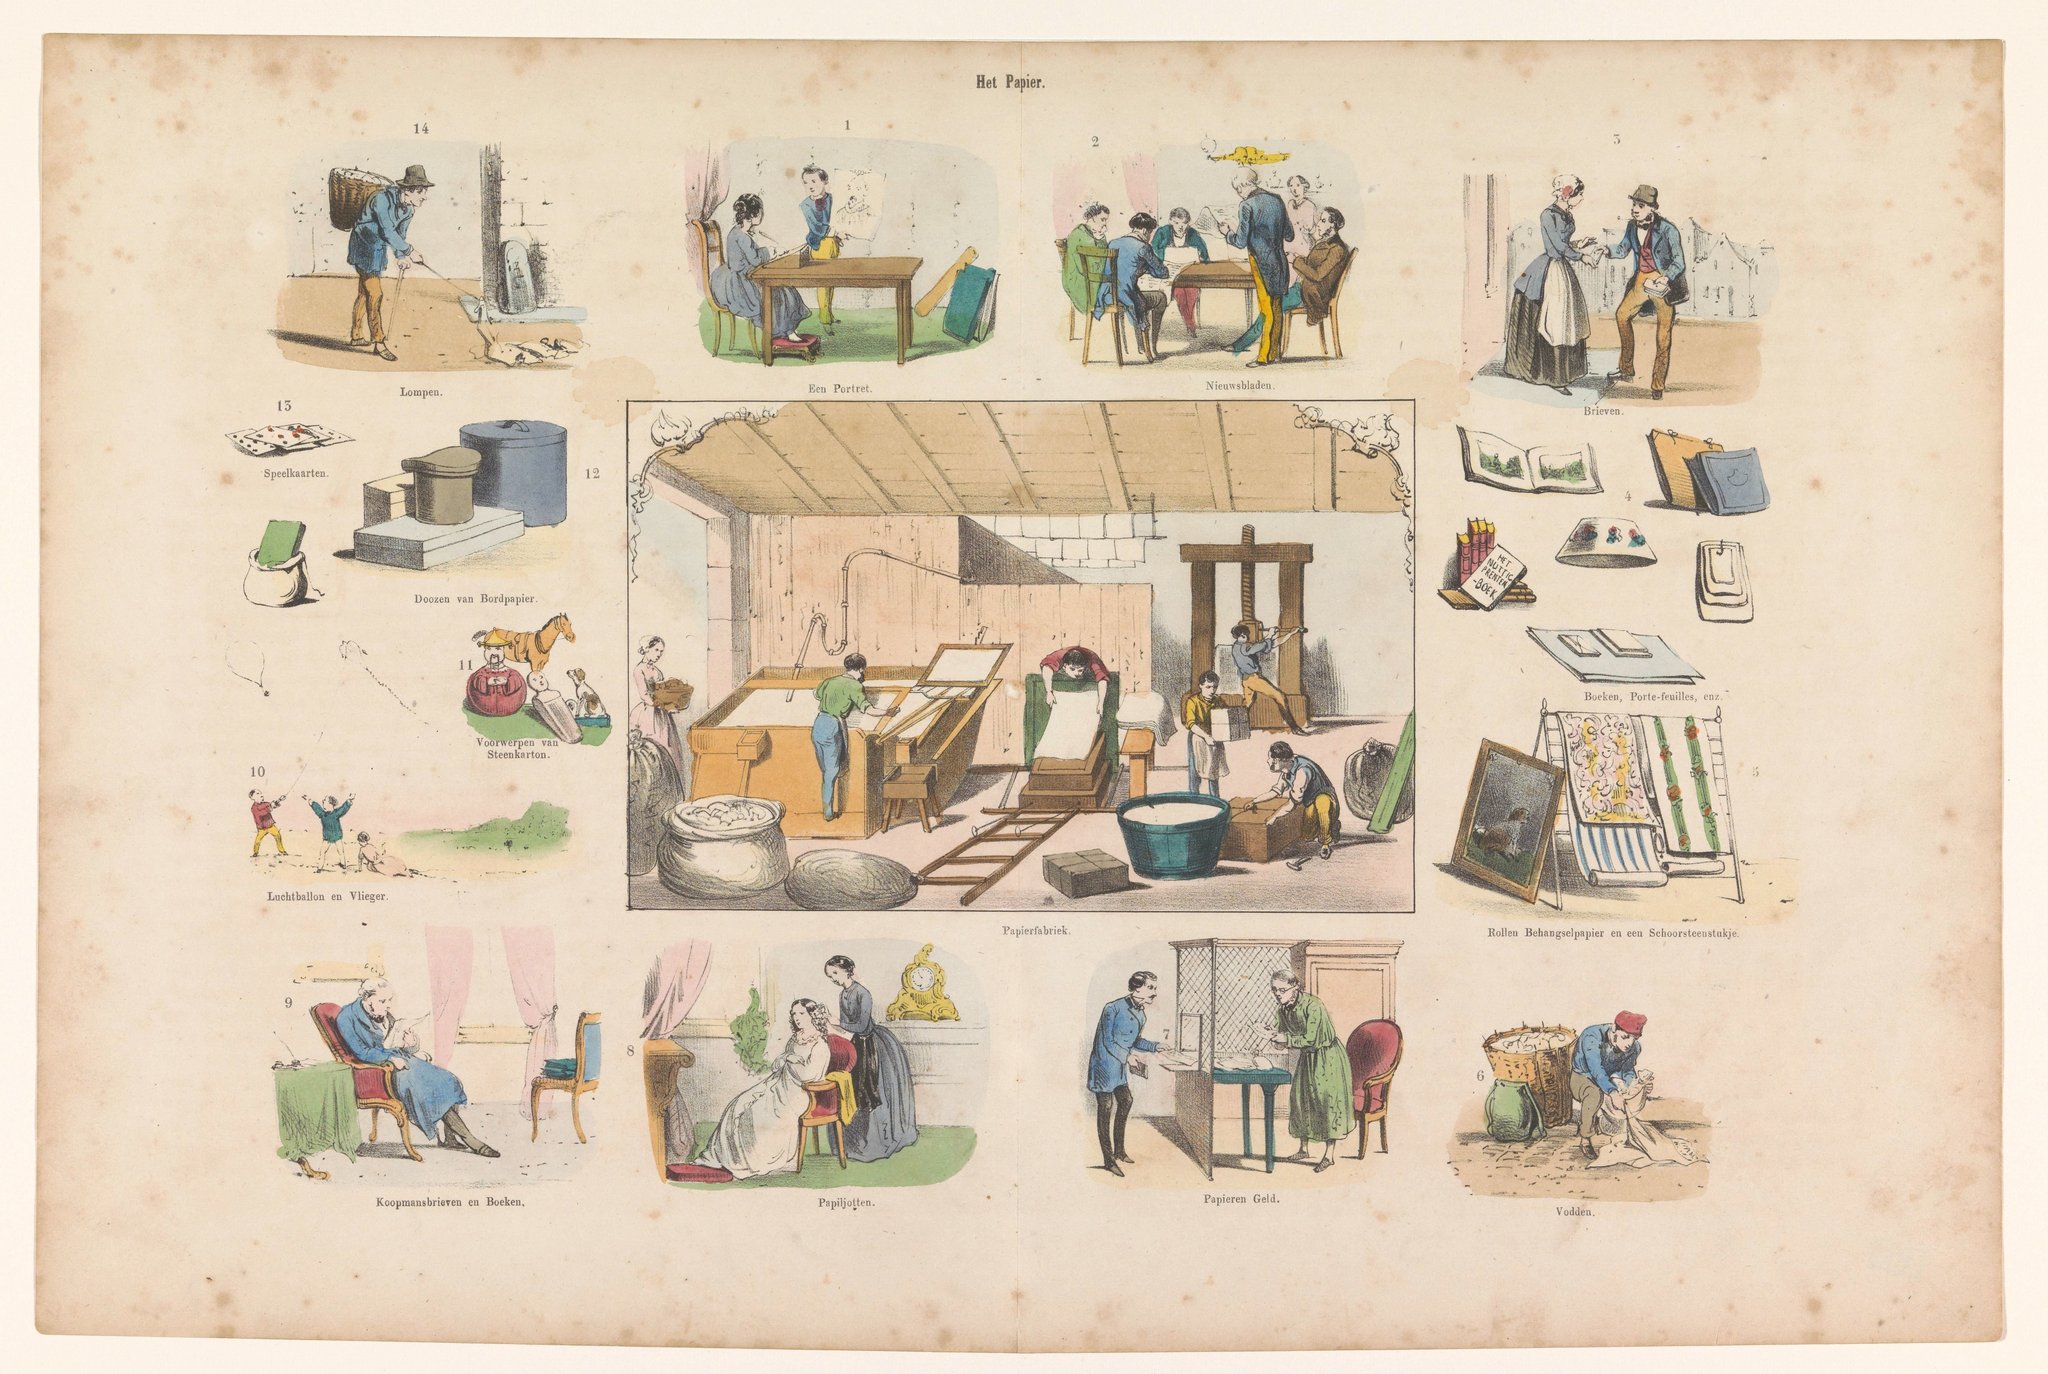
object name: print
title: Productie en gebruik van papier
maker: Anonymous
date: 1850-1900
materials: paper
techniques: hand coloring, lithograph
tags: handicrafts, craftsman at work, reading, money-changer, paper (writing material), garbage collection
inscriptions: collector's mark: Lugt 2228, collector's mark: Lugt 4779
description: Blad met in het midden het interieur van een papiermakerij. Daarboven een verzamelaar van lompen, een kind dat een portret omhoog houdt, mannen die de krant lezen en een postbezorger. Daaronder een koopman lezend in zijn stoel, een vrouw met papillotten in haar haar, een geldwisselaar en een verzamelaar van vodden. Links en rechts van de centrale scène producten die uit papier vervaardigd zijn.